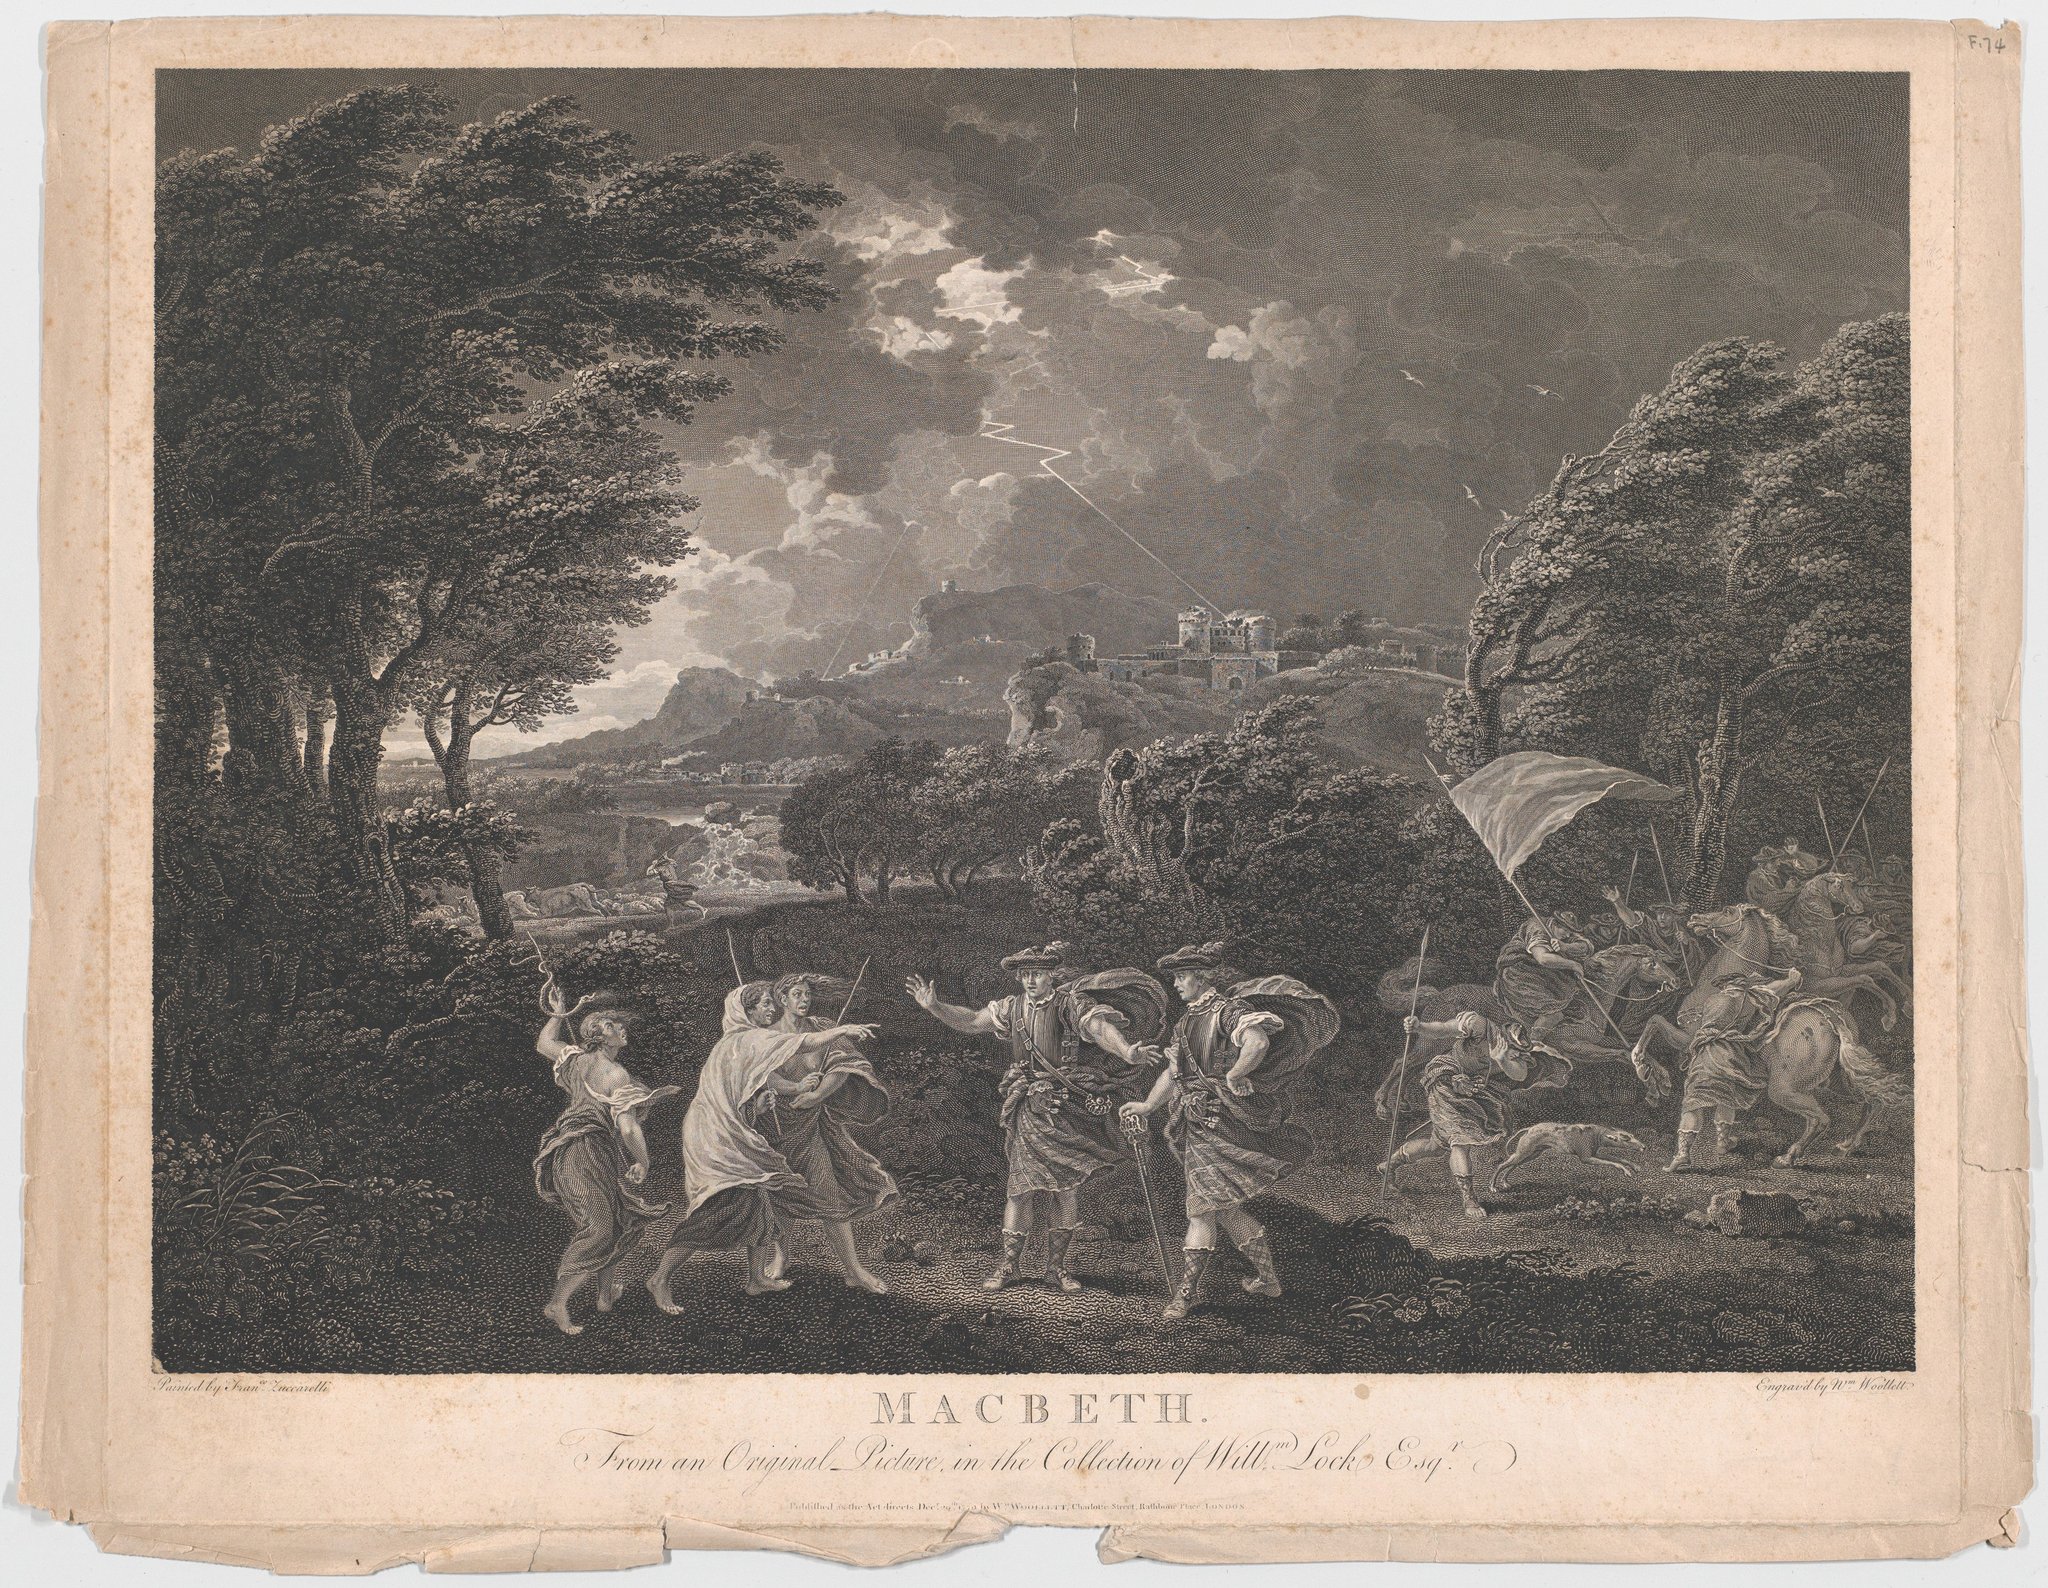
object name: print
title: Macbeth and the Witches (Shakespeare, Macbeth, Act 1, Scene 1)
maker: william woollett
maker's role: engraver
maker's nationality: british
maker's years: 1735-1785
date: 1770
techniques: engraving, etching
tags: shakespeare,men,women,witches,macbeth